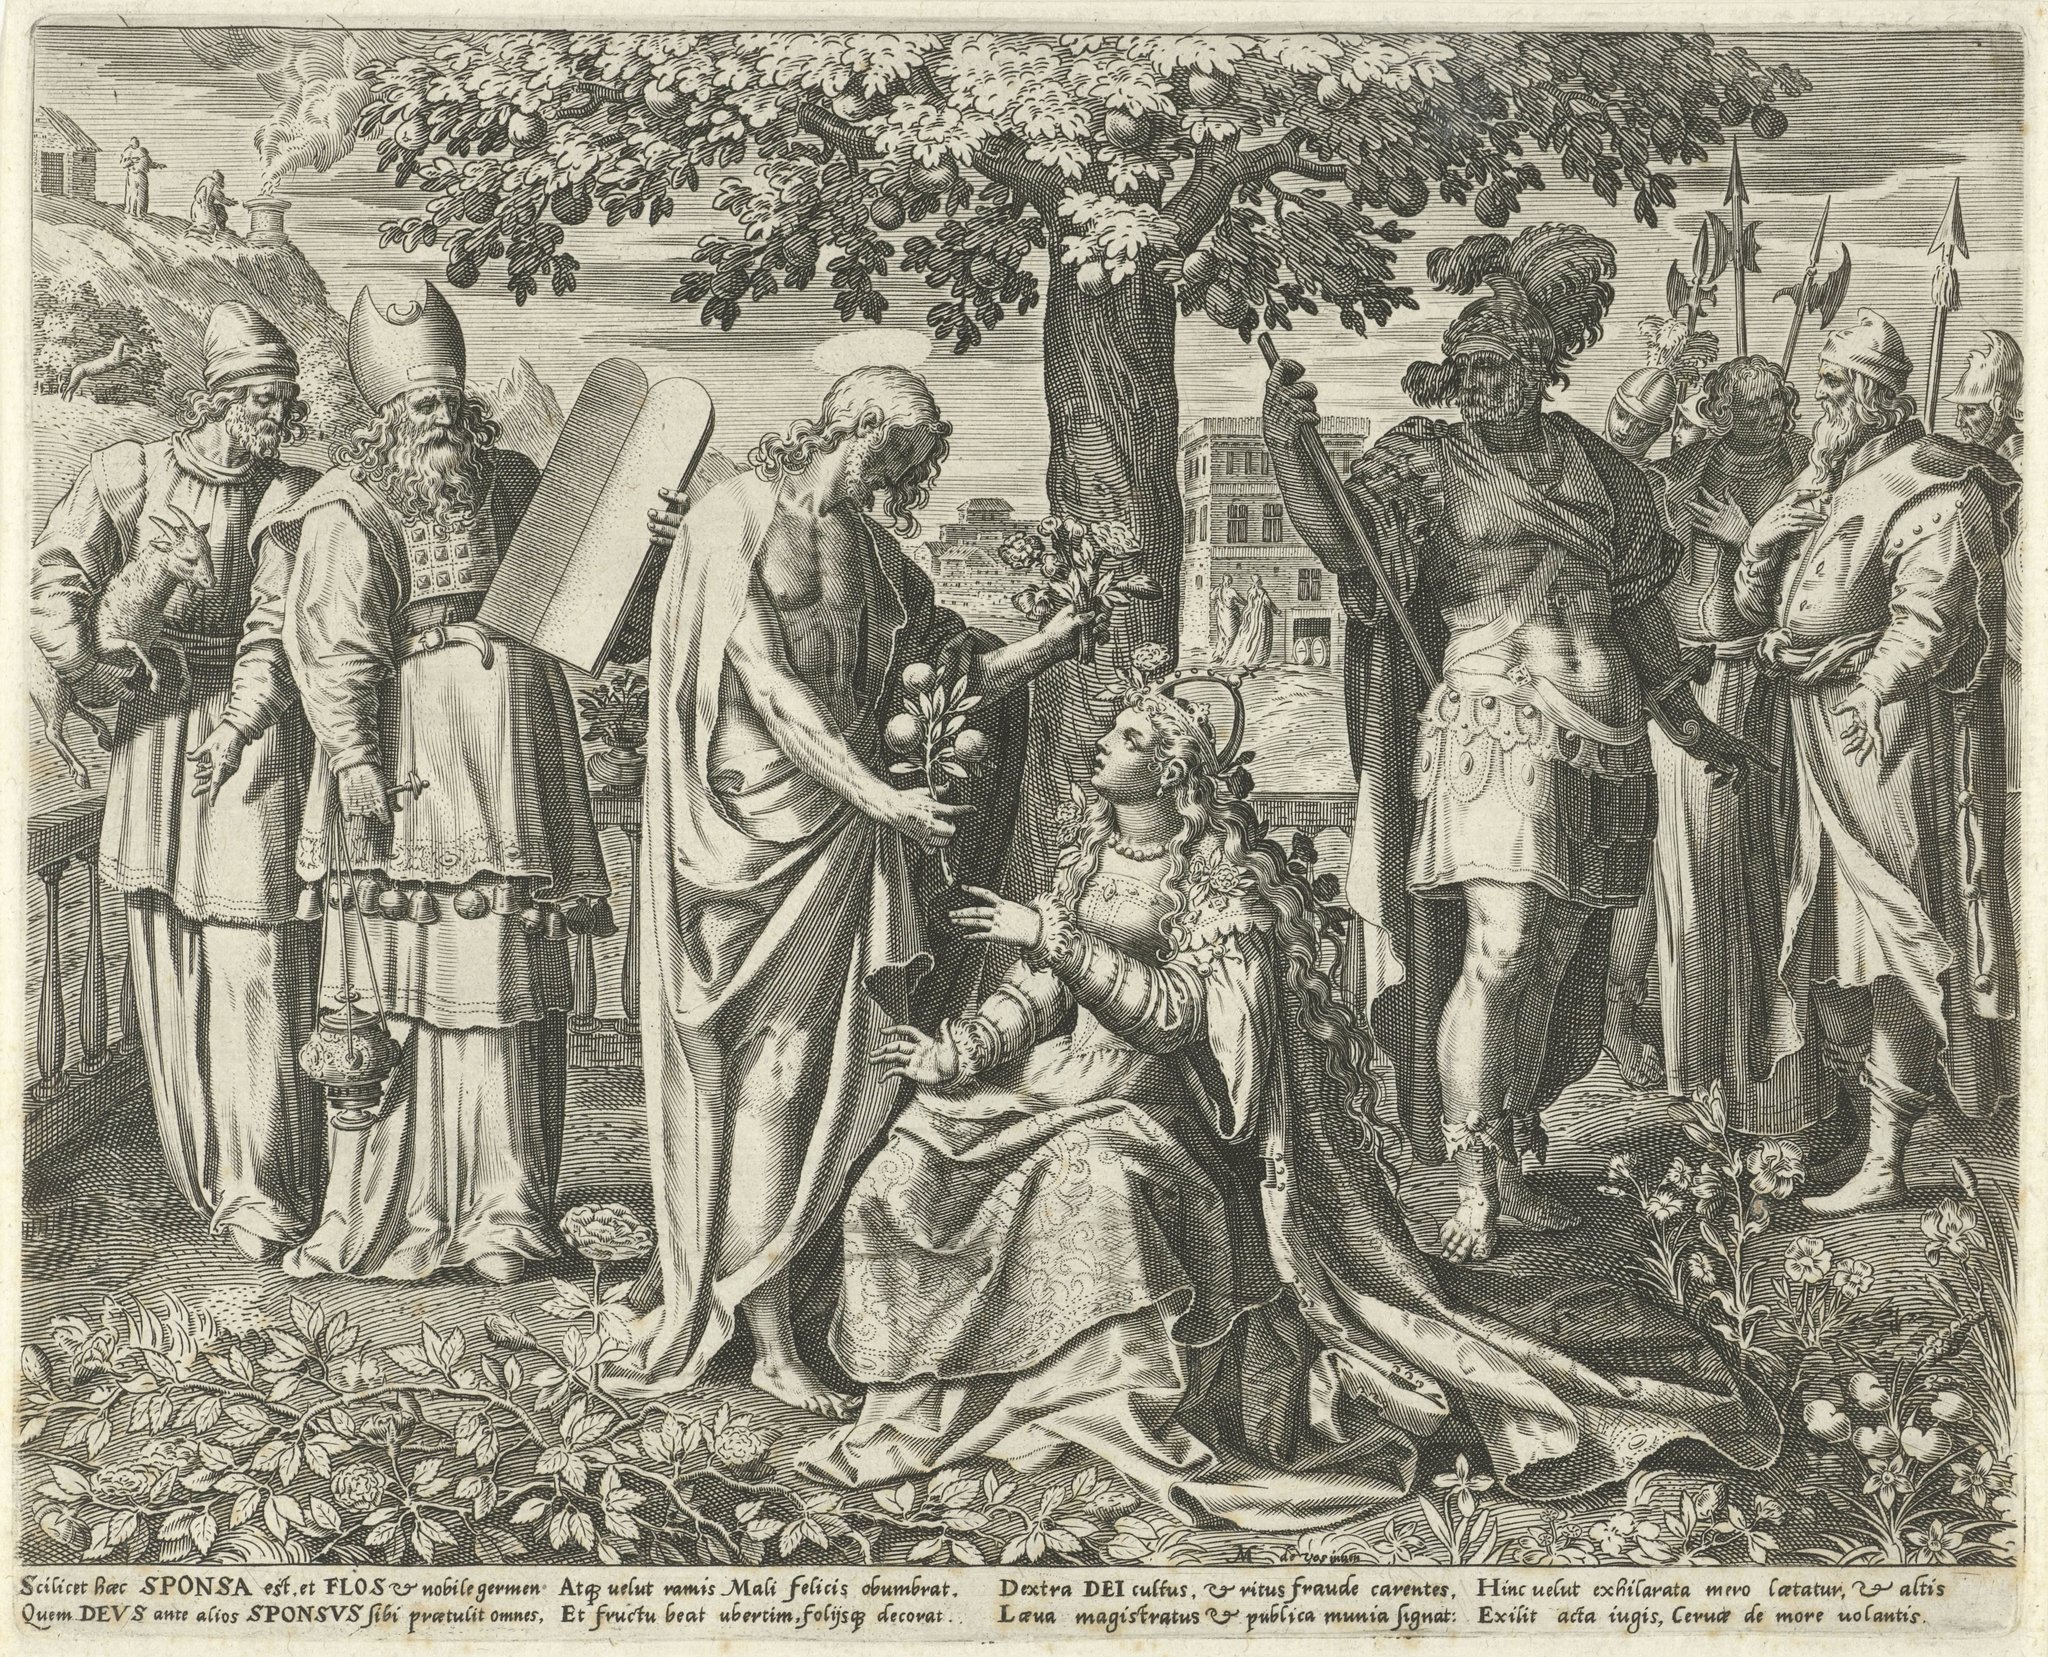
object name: print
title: Christus en zijn bruid onder een appelboom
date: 1590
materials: paper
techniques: engraving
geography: antwerp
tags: 'ecclesia' as bride of christ (the lamb), 'ecclesia sponsa dei', 'sponsus-sponsa', song of solomon, song of songs (with book chapter:verse) (+ christ bearded), garden, groups of persons from the old testament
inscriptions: collector's mark: Lugt 240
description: De bruid van Christus (de kerk) zit onder een appelboom in een bloementuin en ontvangt bloemen van Christus die naast haar staat. Links en rechts personen uit het Oude Testament. De prent heeft een Latijns onderschrift over het hooglied van Salomo en is de tweede prent van een zesdelige serie.